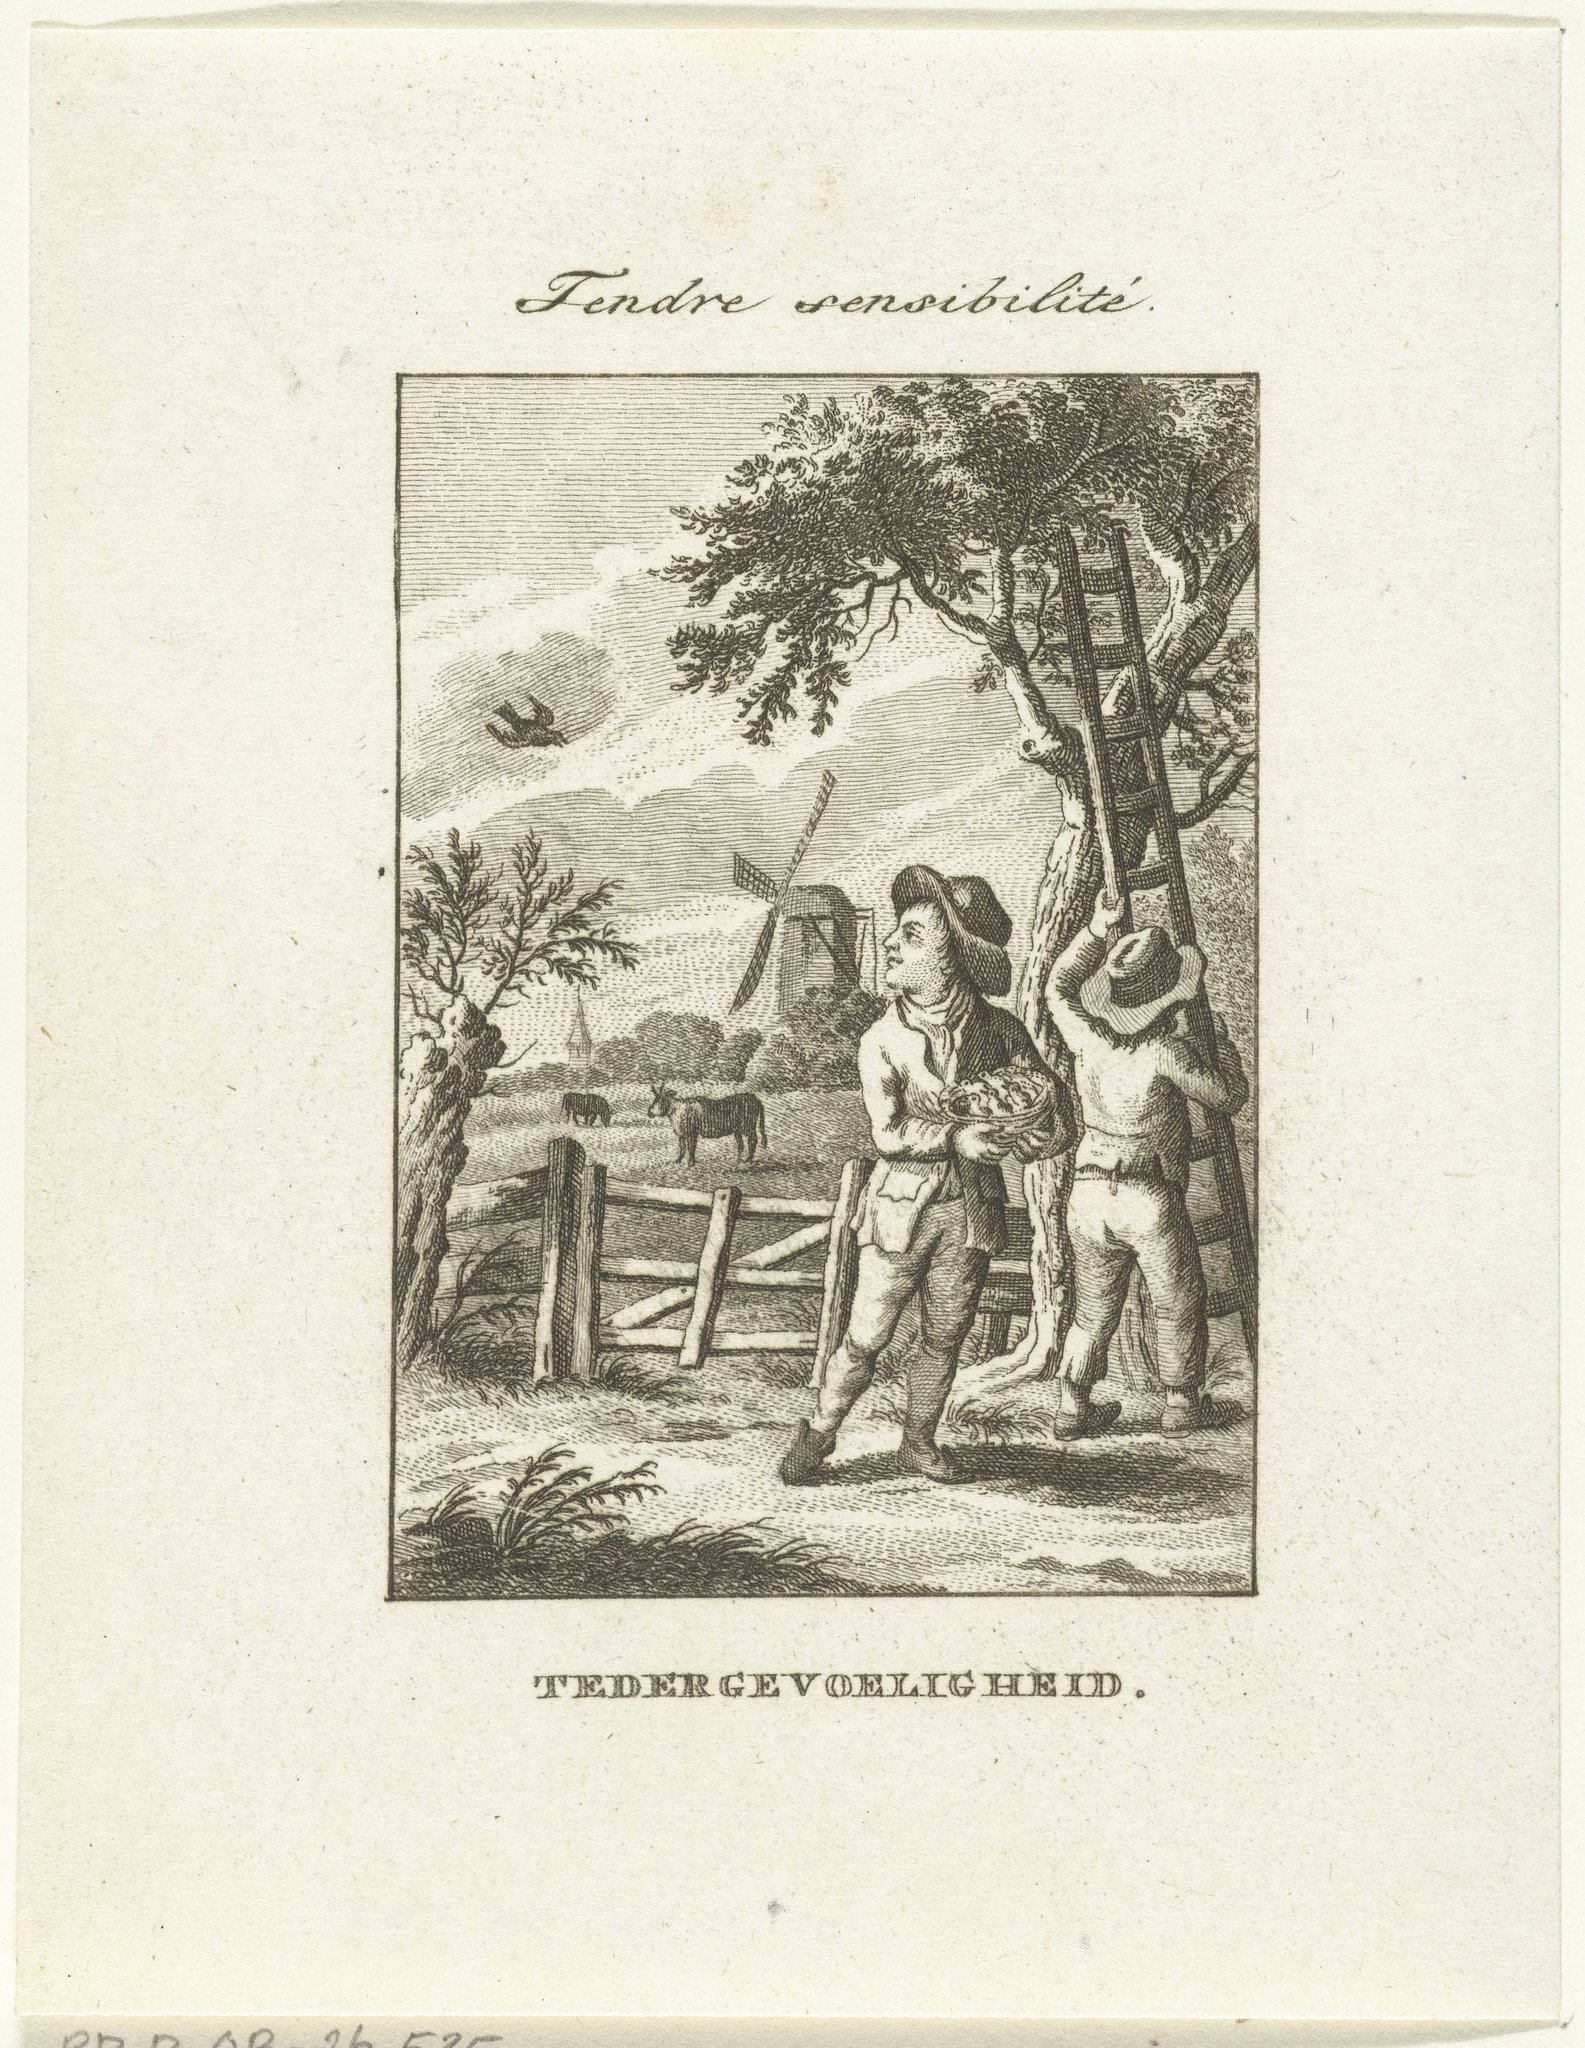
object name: print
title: Twee jongens zetten nest jonge vogels terug in boom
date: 1781-1799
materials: paper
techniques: etching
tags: sensation, sensibility, sensitivity, youth, adolescent, child and nature (games and plays)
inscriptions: collector's mark: Lugt 2228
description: Prent uit: Aangenaam Kinderschool, wed. J. Dóll (uitgever), eerste druk, Amsterdam 1781. Mogelijk uit tweede, derde of vierde druk en op basis daarvan datering periode 1781-1799. Prent naar tekening van Isaac van Haastert.